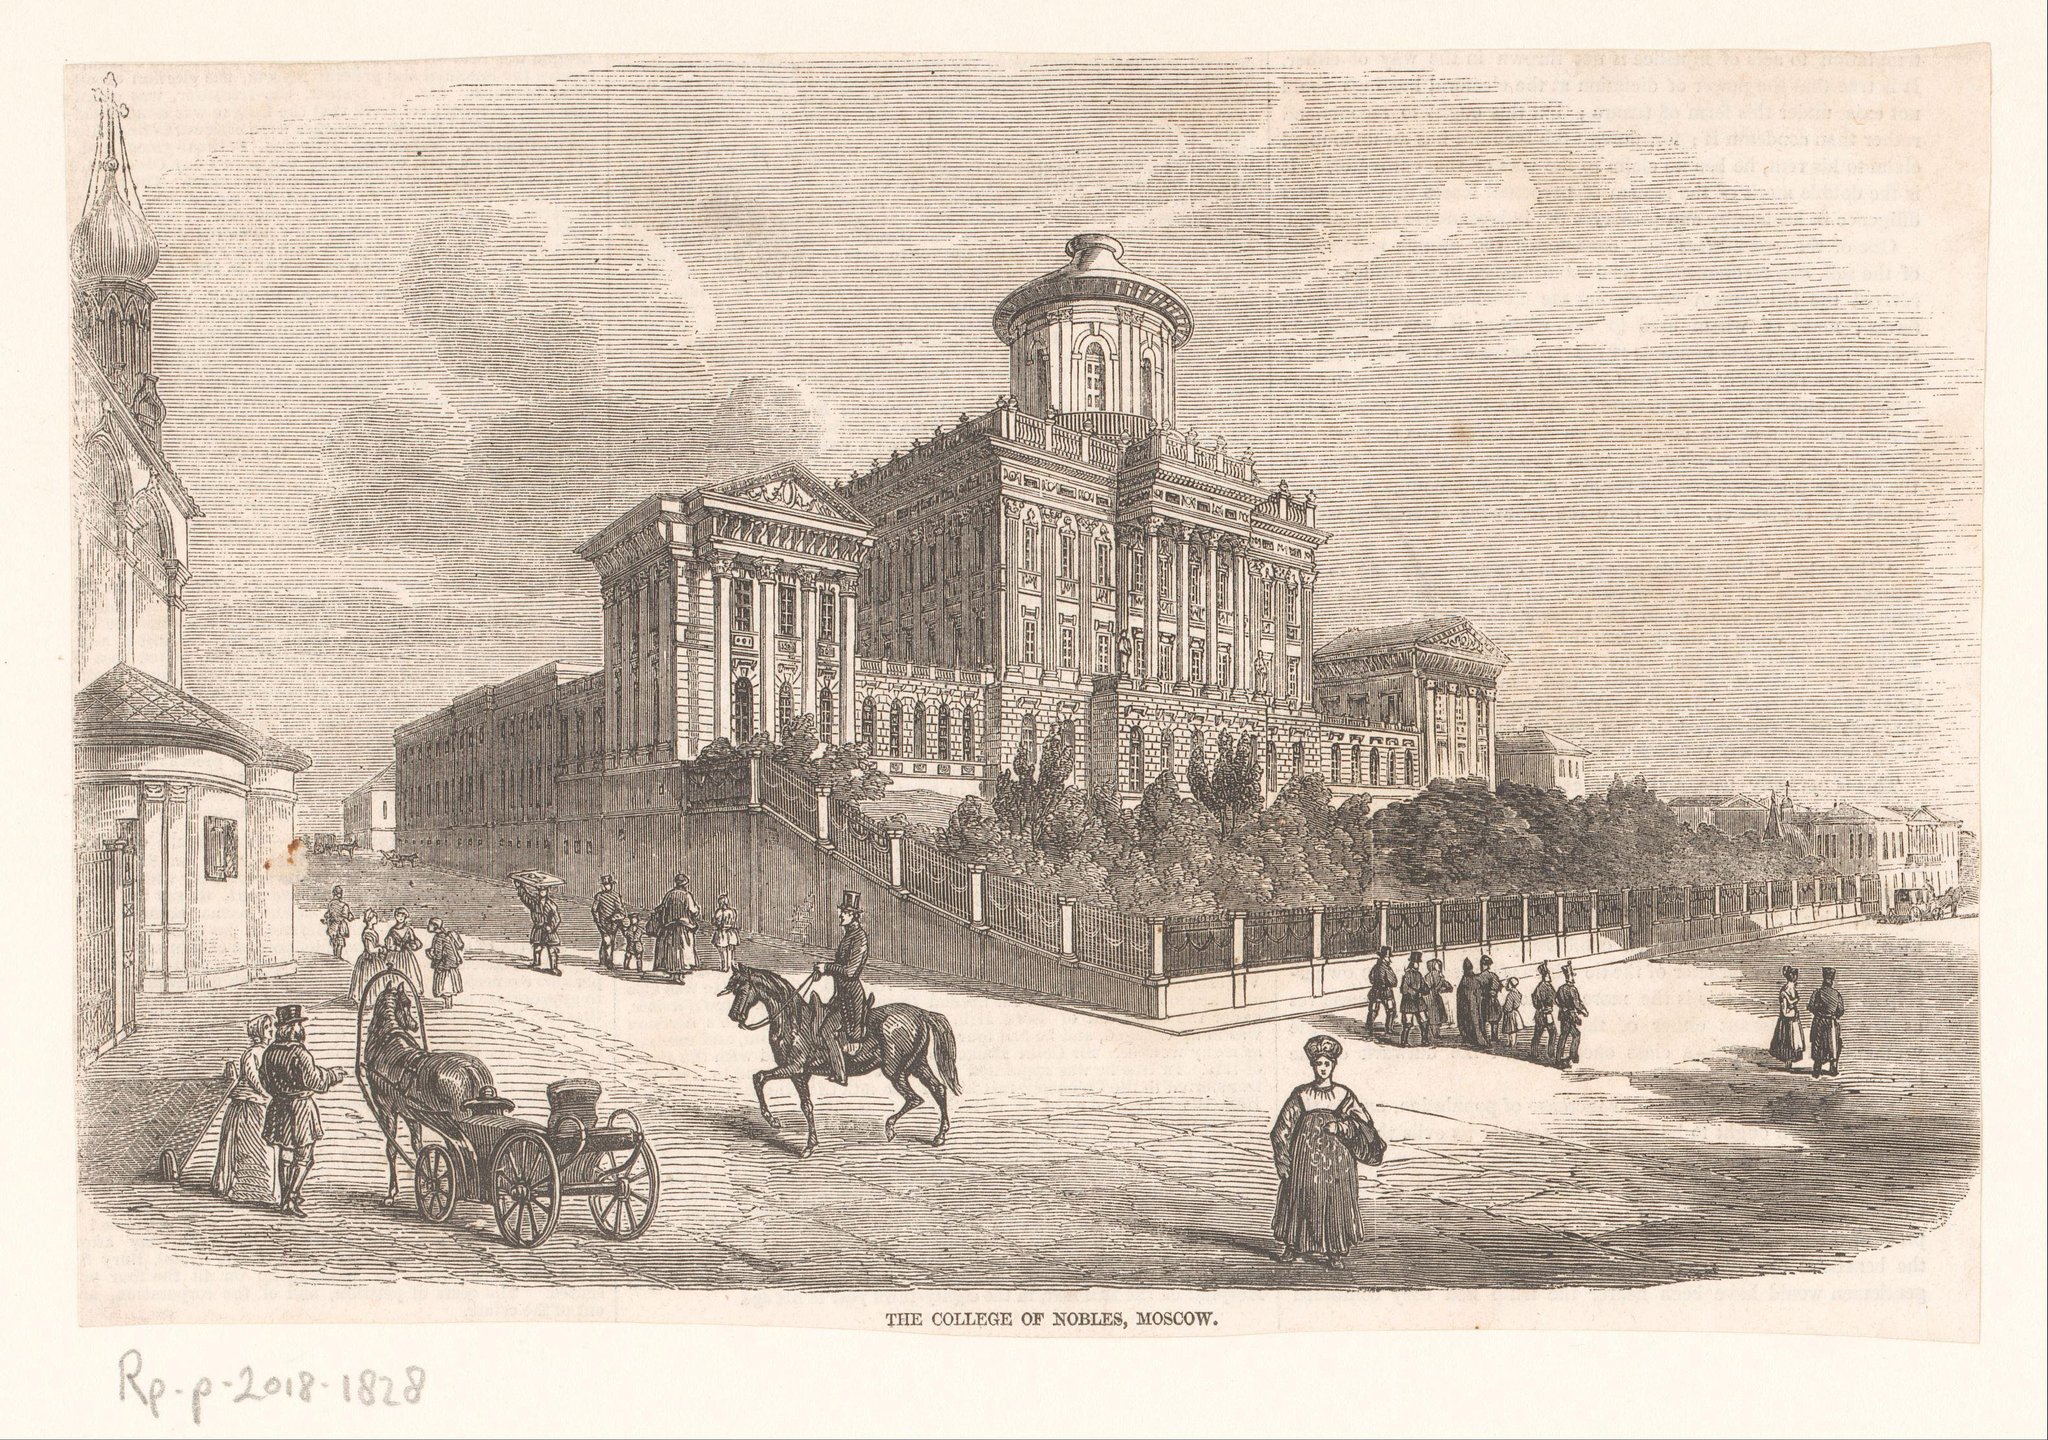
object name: print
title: The College of Nobles, Moscow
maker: Anonymous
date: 1856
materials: paper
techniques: letterpress printing, engraving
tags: university building, college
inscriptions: collector's mark: Lugt 2228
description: Prent gebruikt in: The Illustrated London News, 27 september 1856.